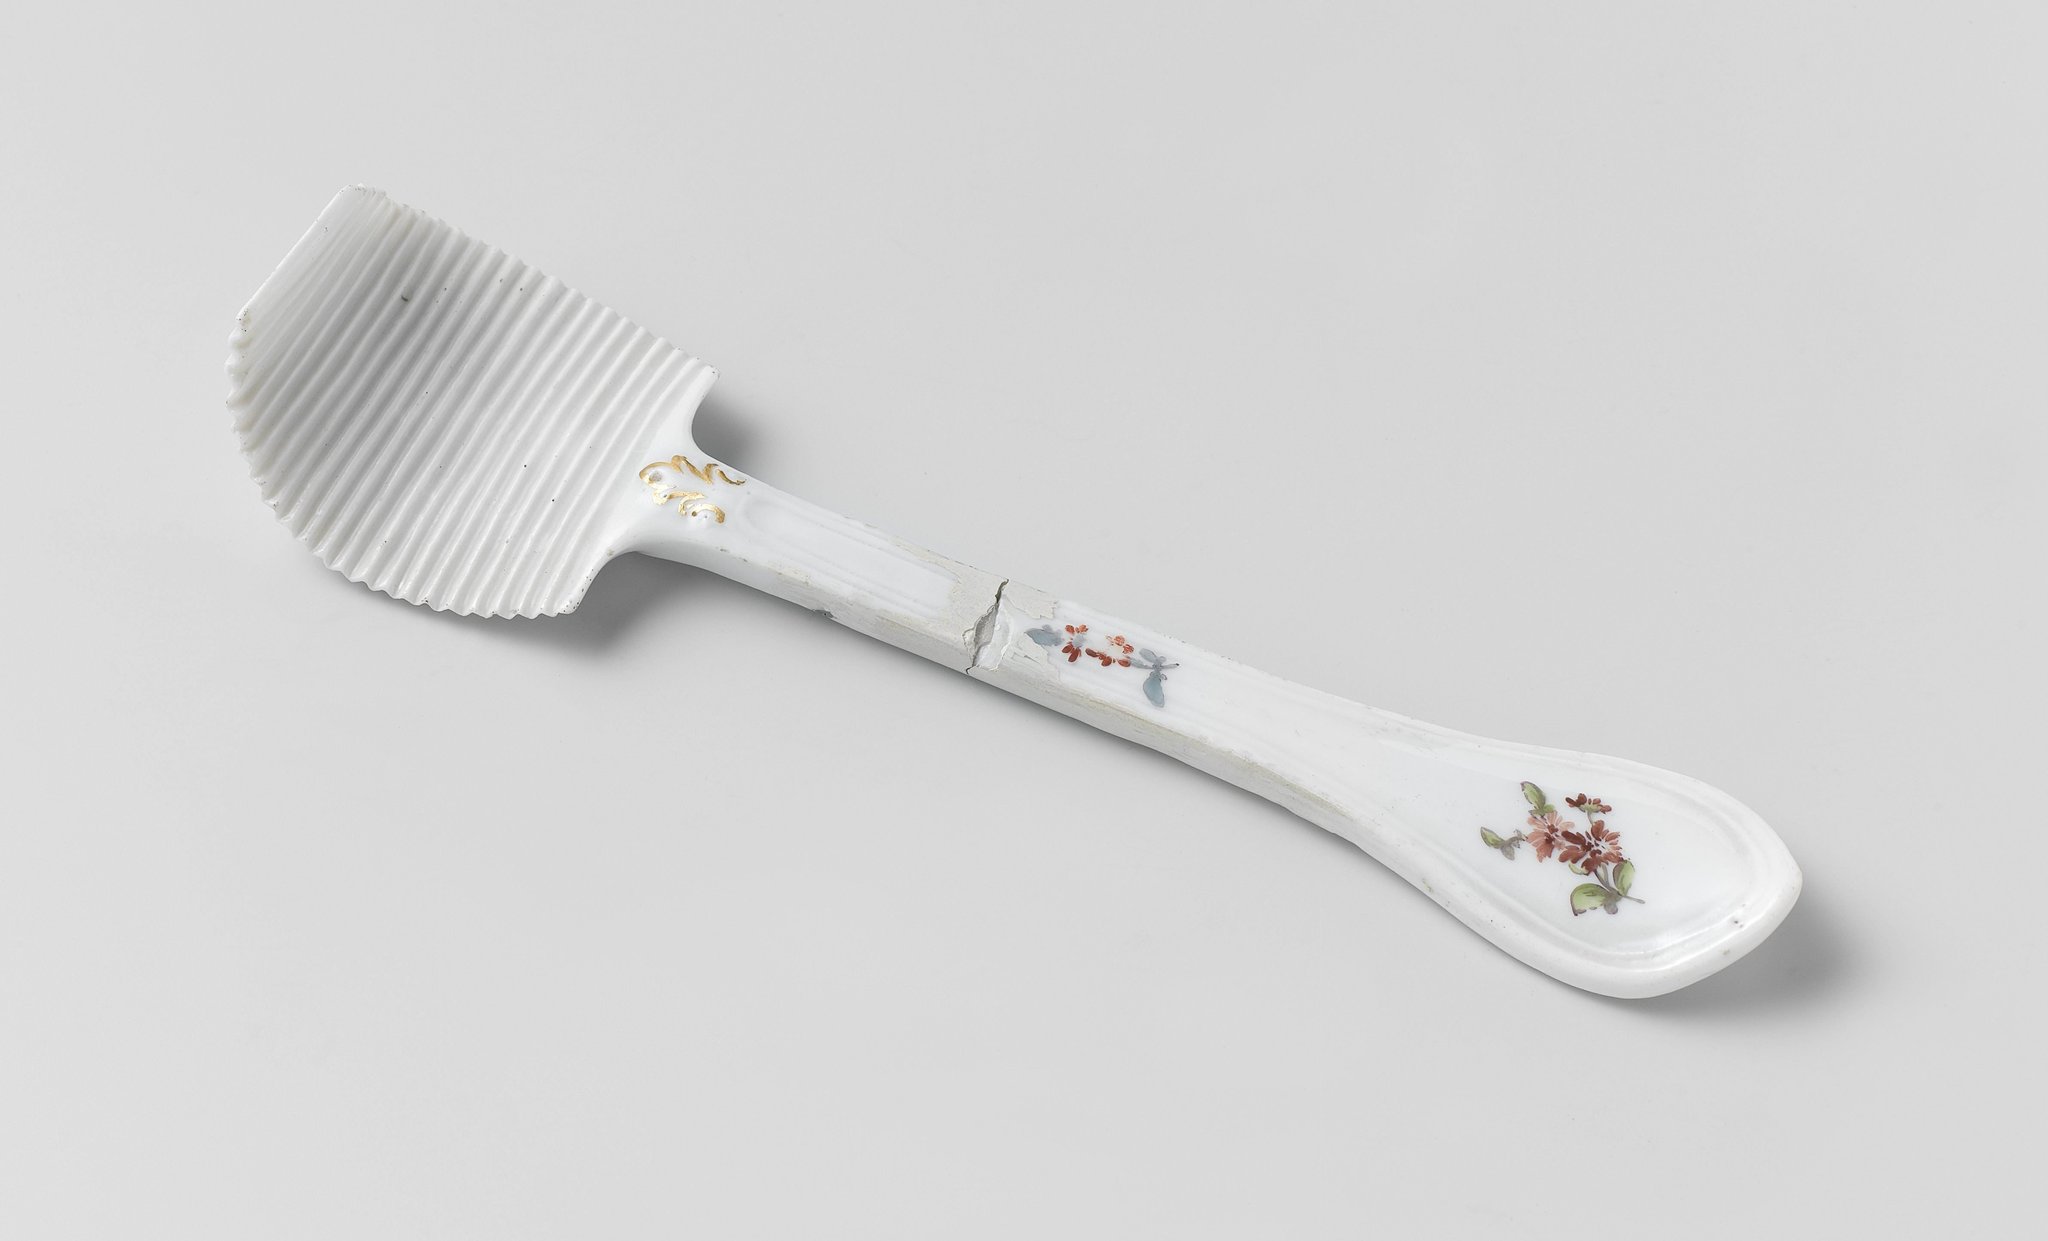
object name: eating drinking utensil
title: Boterspaan, veelkleurig beschilderd met Deutsche Blumen, insekten en vruchten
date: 1750-1760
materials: porcelain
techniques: painted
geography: meissen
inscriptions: factory mark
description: Boterspaan van beschilderd porselein. De bak is omgekruld en geribd. De boterspaan is beschilderd met Deutsche Blumen, insekten en vruchten. De boterspaan is gemerkt en hoort bij een servies (BK-17474-1 t/m BK-17474-253).